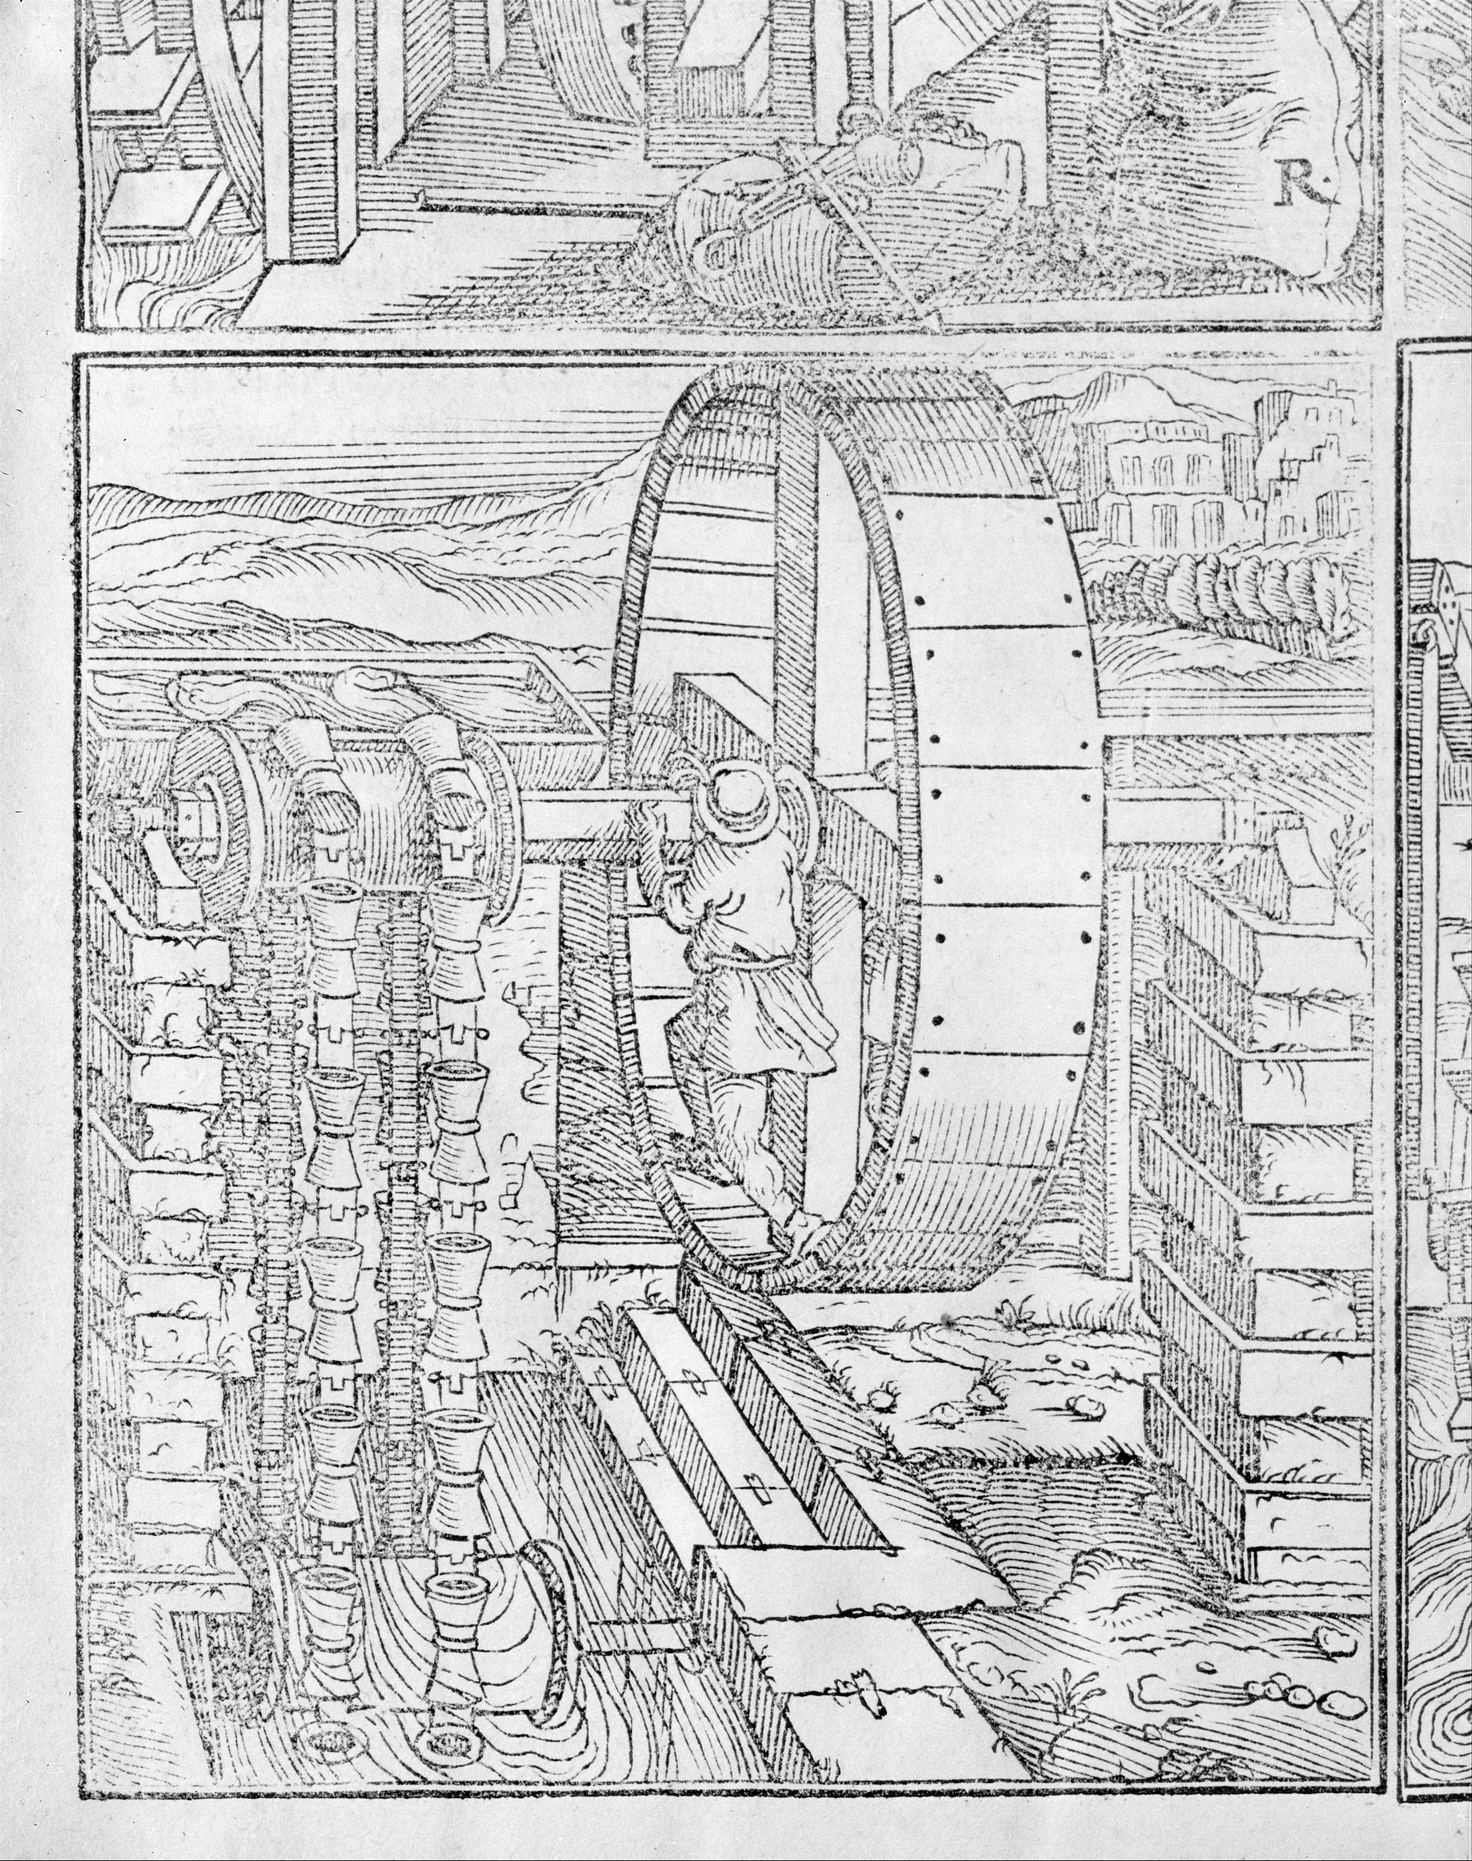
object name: book print ornament architecture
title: I dieci libri dell'architettura di M. Vitruvio tradutti et commentati da monsignor Barbaro eletto patriarca d'aquileggia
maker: marcus pollio vitruvius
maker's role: author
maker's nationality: italian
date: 1556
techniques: printing, woodcut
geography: italy